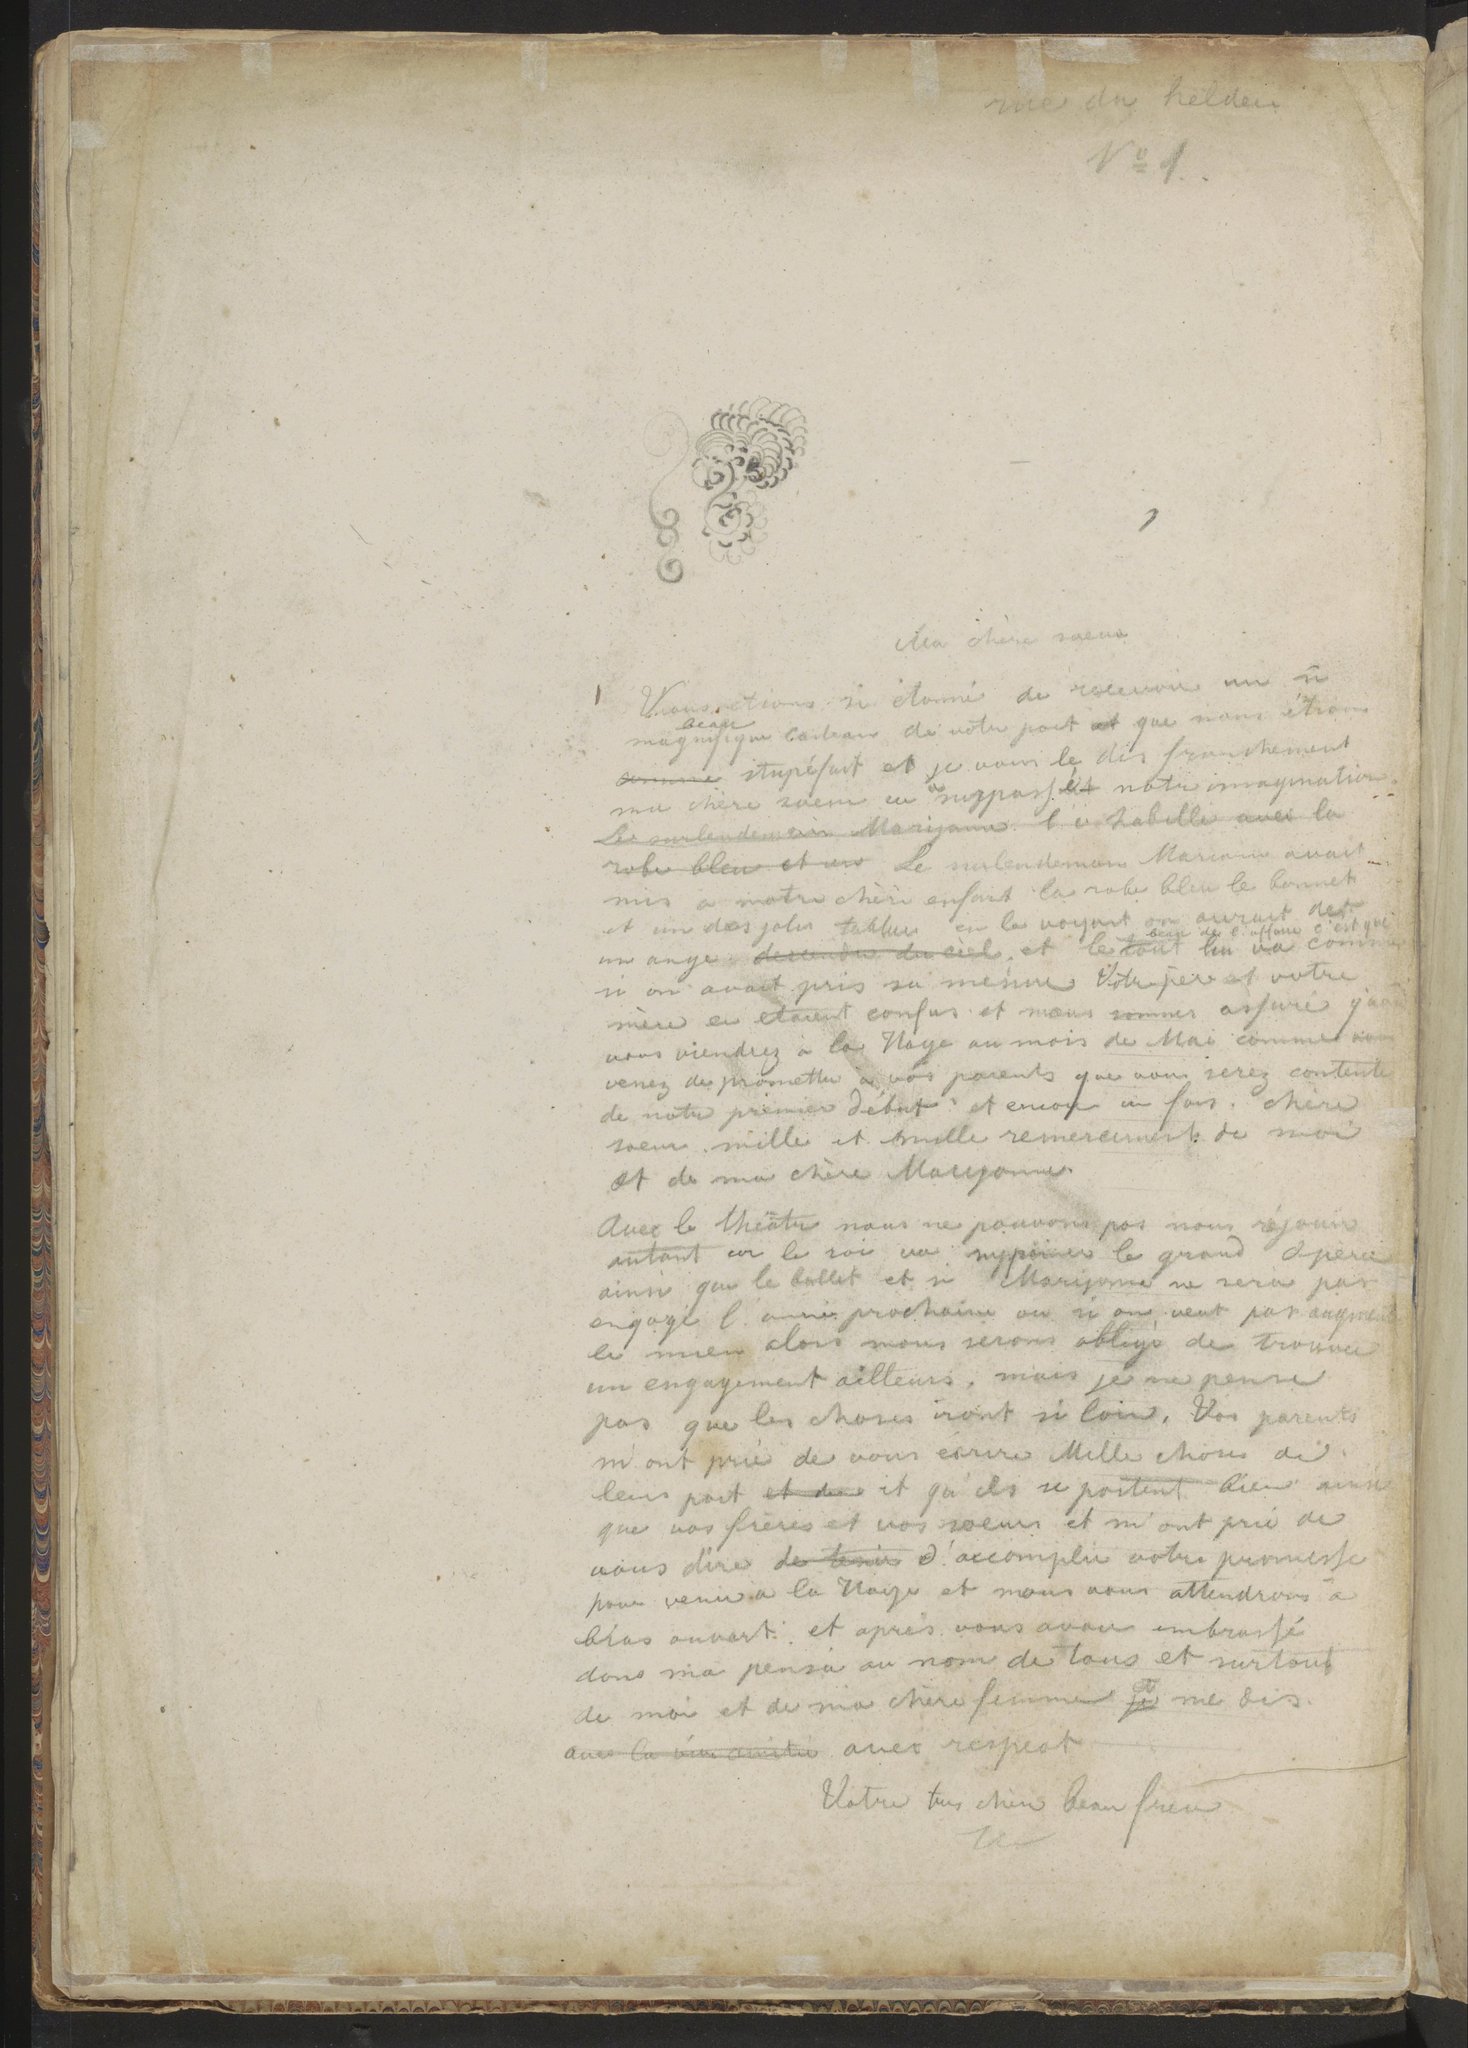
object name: sketchbook leaf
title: Brief versierd met bloemornament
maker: johannes huybertus van hove bzn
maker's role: print maker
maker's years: 1827-1881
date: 1837-1881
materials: paper, pencil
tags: flowers ~ ornament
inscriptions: annotation: ‘Ma chère soeur/ [...]’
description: Brief aan de zuster van de kunstenaar. Blad 24 verso uit een schetsboek met 33 bladen en 10 losse tekeningen.